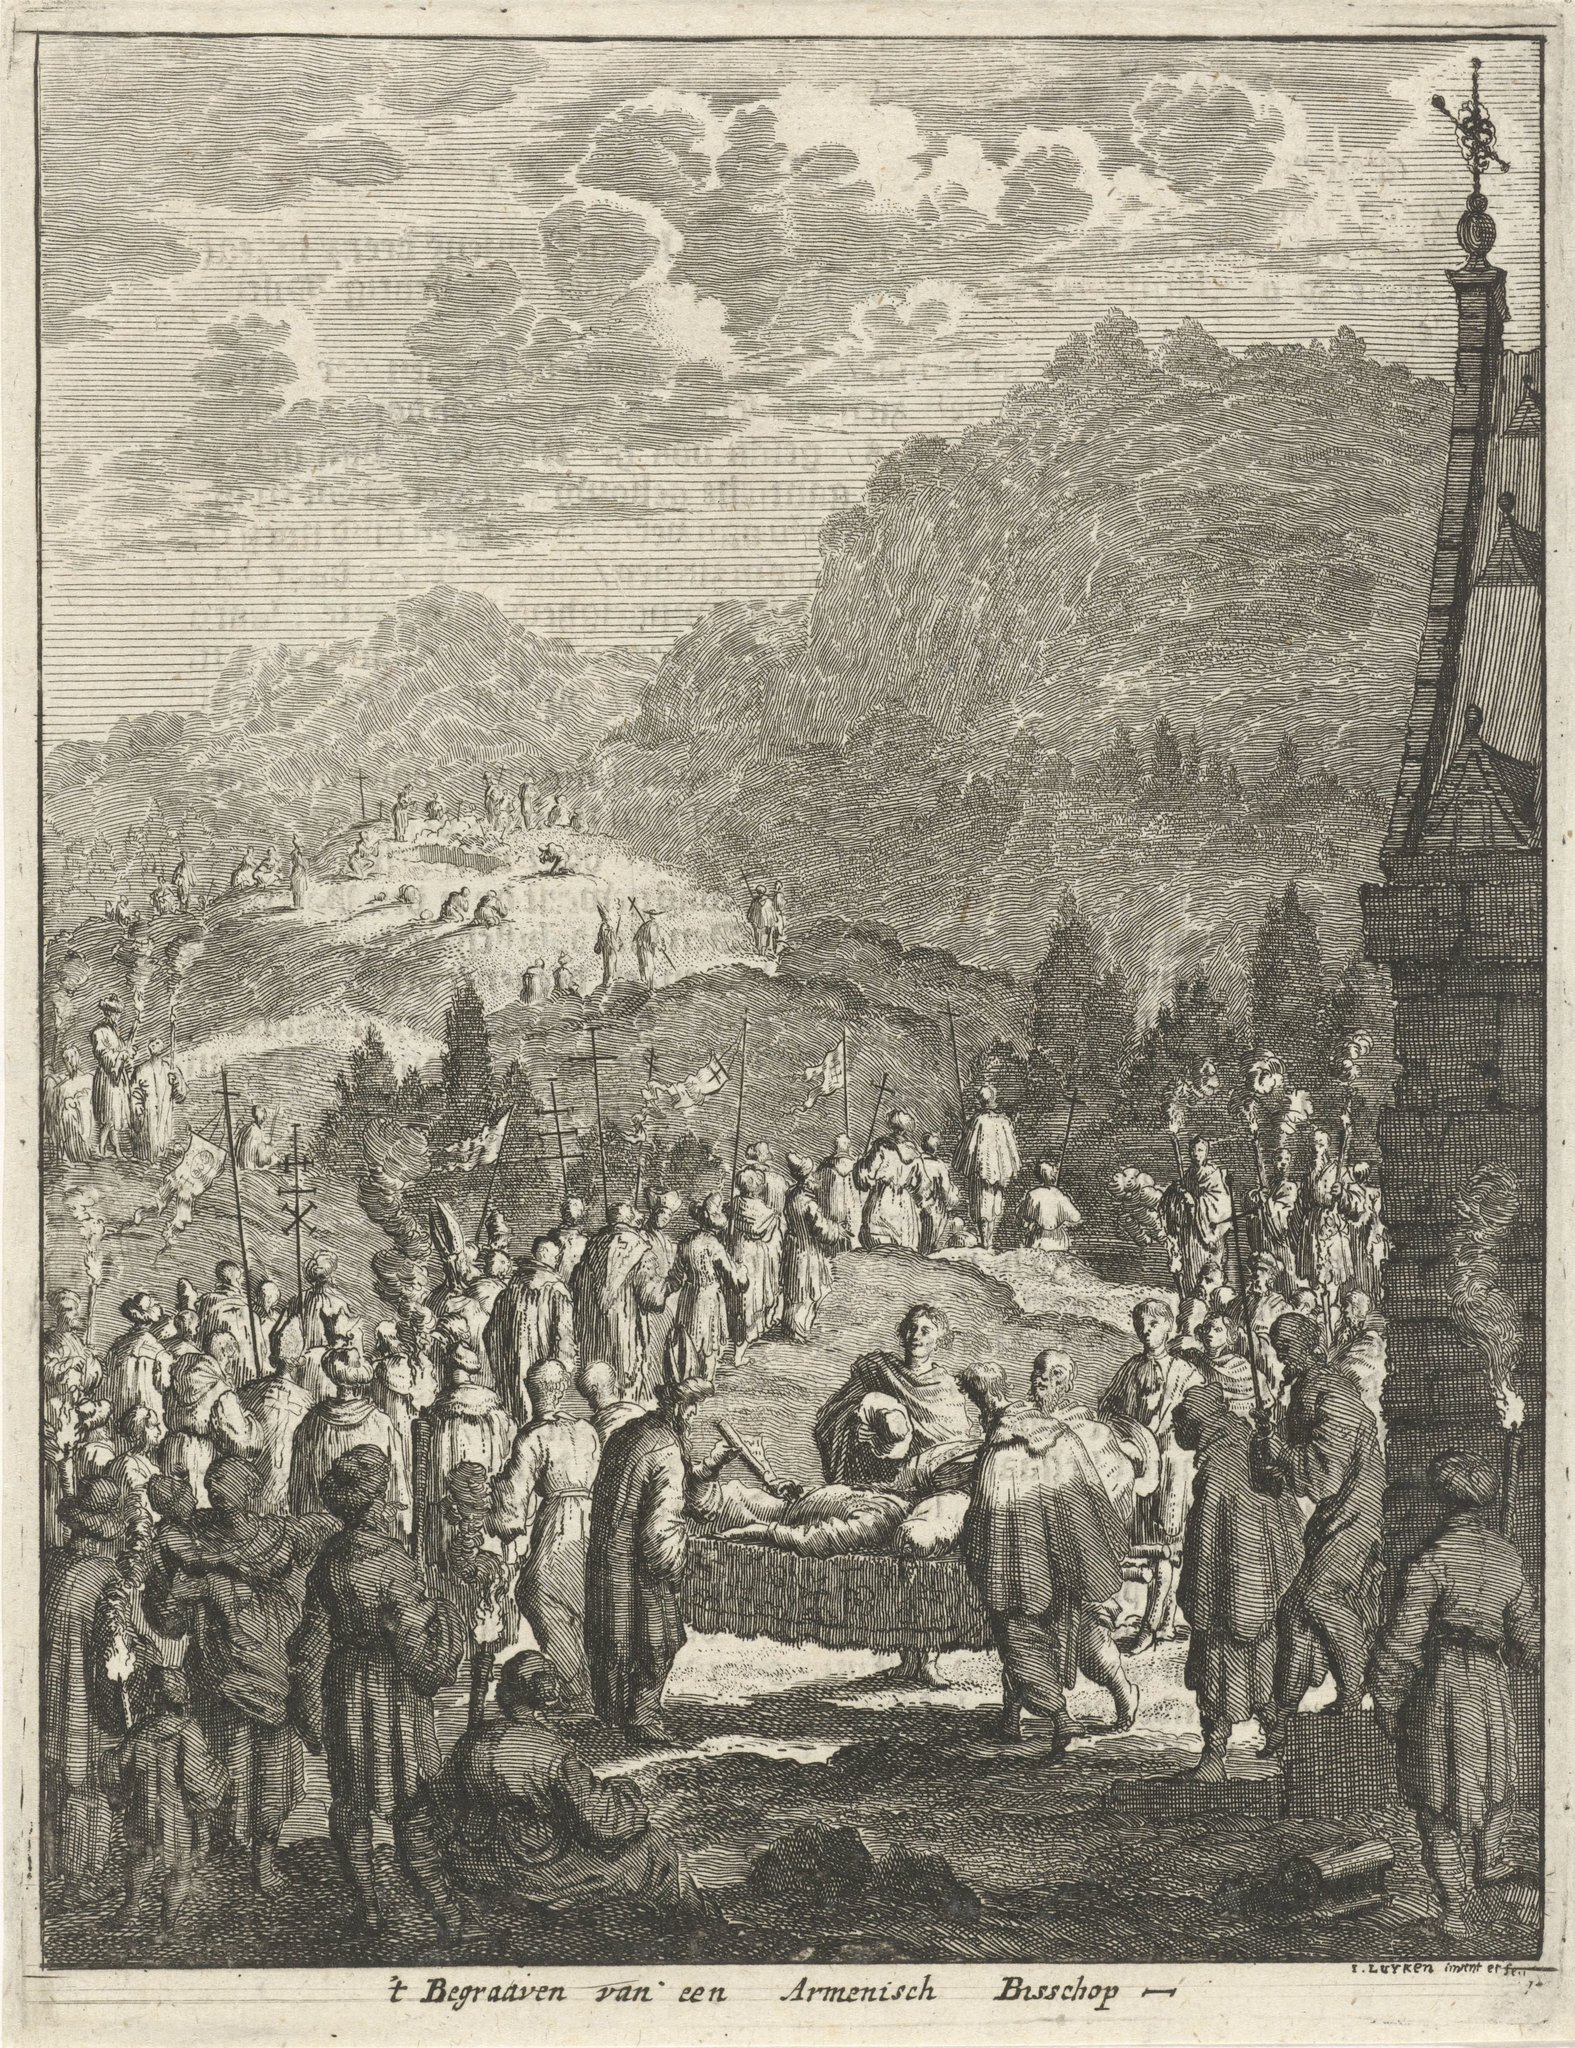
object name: print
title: 't Begraaven van een Armenisch Bisschop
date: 1681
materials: paper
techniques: etching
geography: amsterdam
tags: archbishop, bishop, etc. (roman catholic), funerary ceremonial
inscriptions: collector's mark: Lugt 2228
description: Illustratie opgenomen in: Melton, Edward. Zeldzaame en gedenkwaardige zee- en landreizen, p. 271. Amsterdam: Jan Claesz ten Hoorn, 1681.